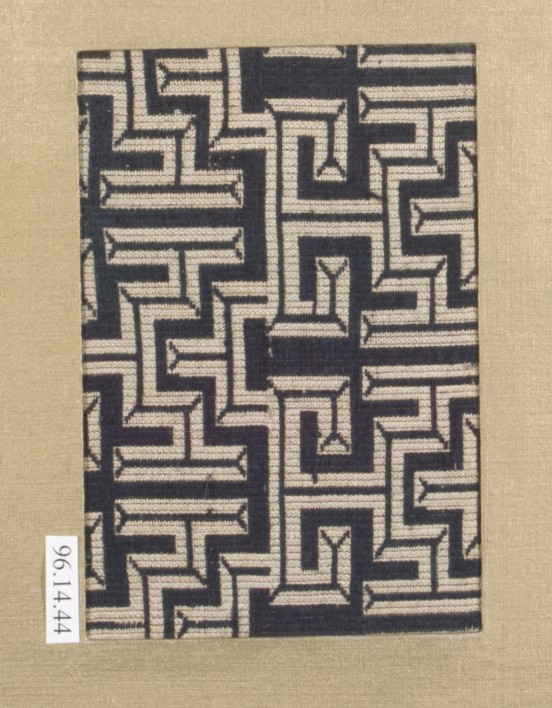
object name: piece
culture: japanese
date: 1701-1800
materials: silk